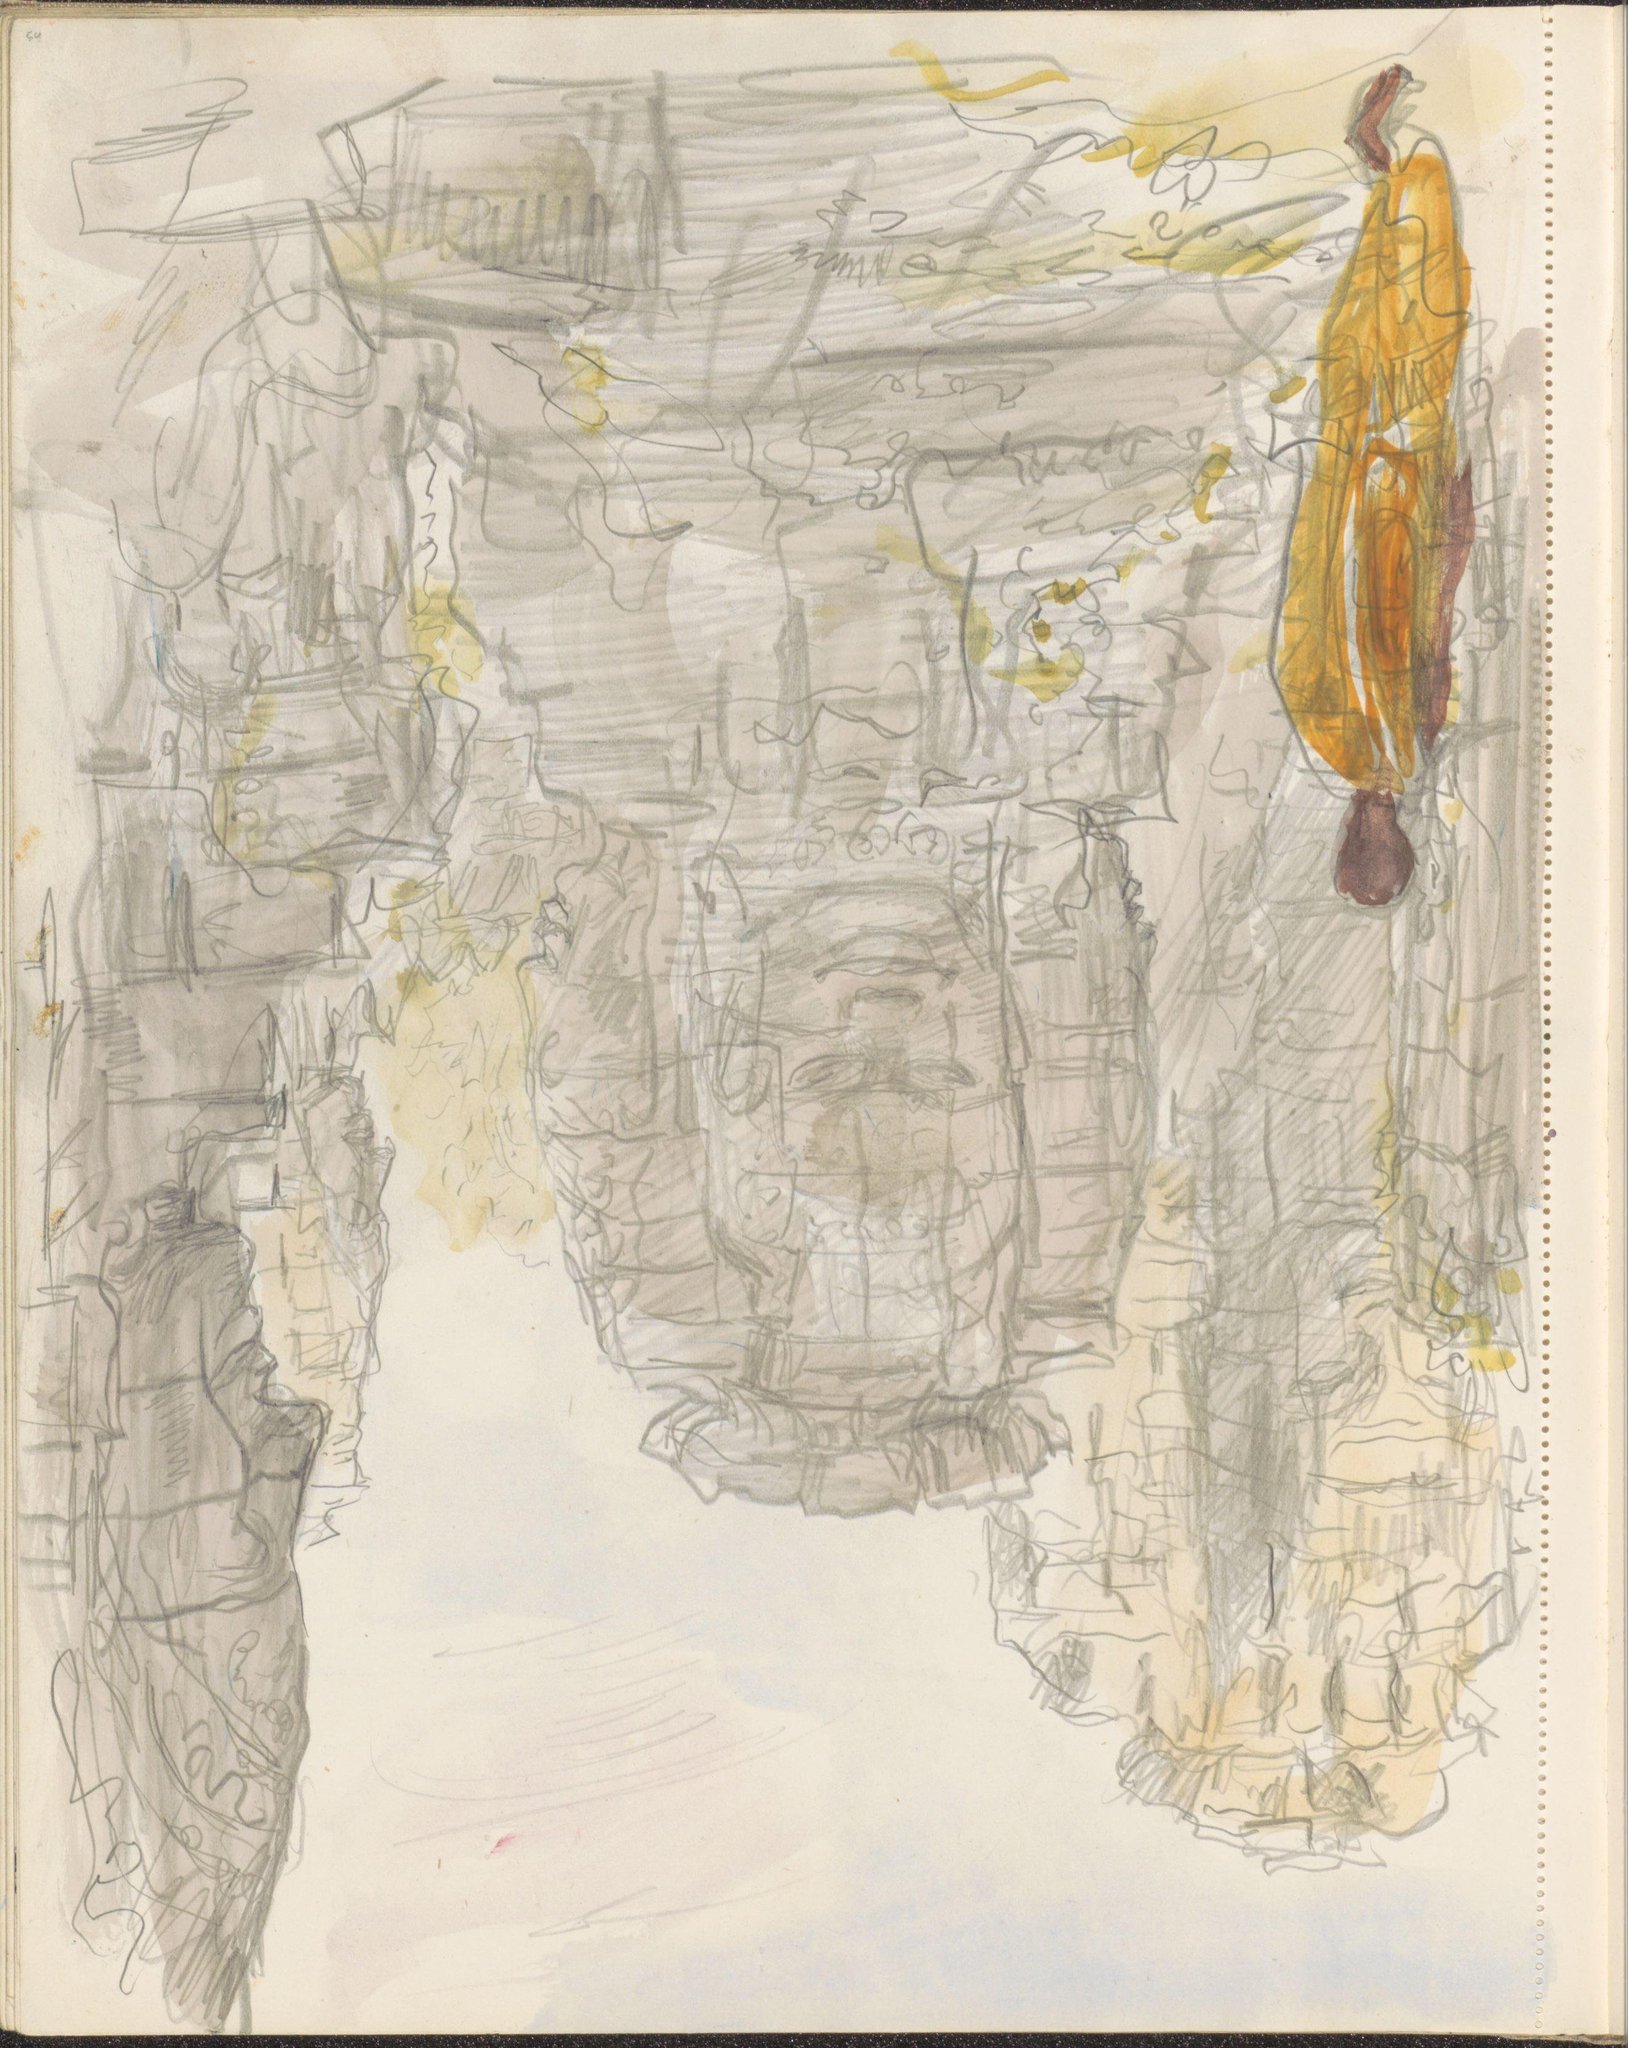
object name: sketchbook leaf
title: Uit steen gehouwen hoofden van Brahma bij de Bayontempel in Cambodja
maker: marius bauer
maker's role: draughtsman, print maker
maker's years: 1867-1932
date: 1931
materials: paper, pencil, watercolor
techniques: brush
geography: cambodia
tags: temple, shrine ~ hinduism, buddhism, jainism, sculpture, religious functionaries ~ hinduism, buddhism, jainism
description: Op de voorgrond een Boeddhistische monnik. Pagina 54 uit een schetsboek met 48 bladen.